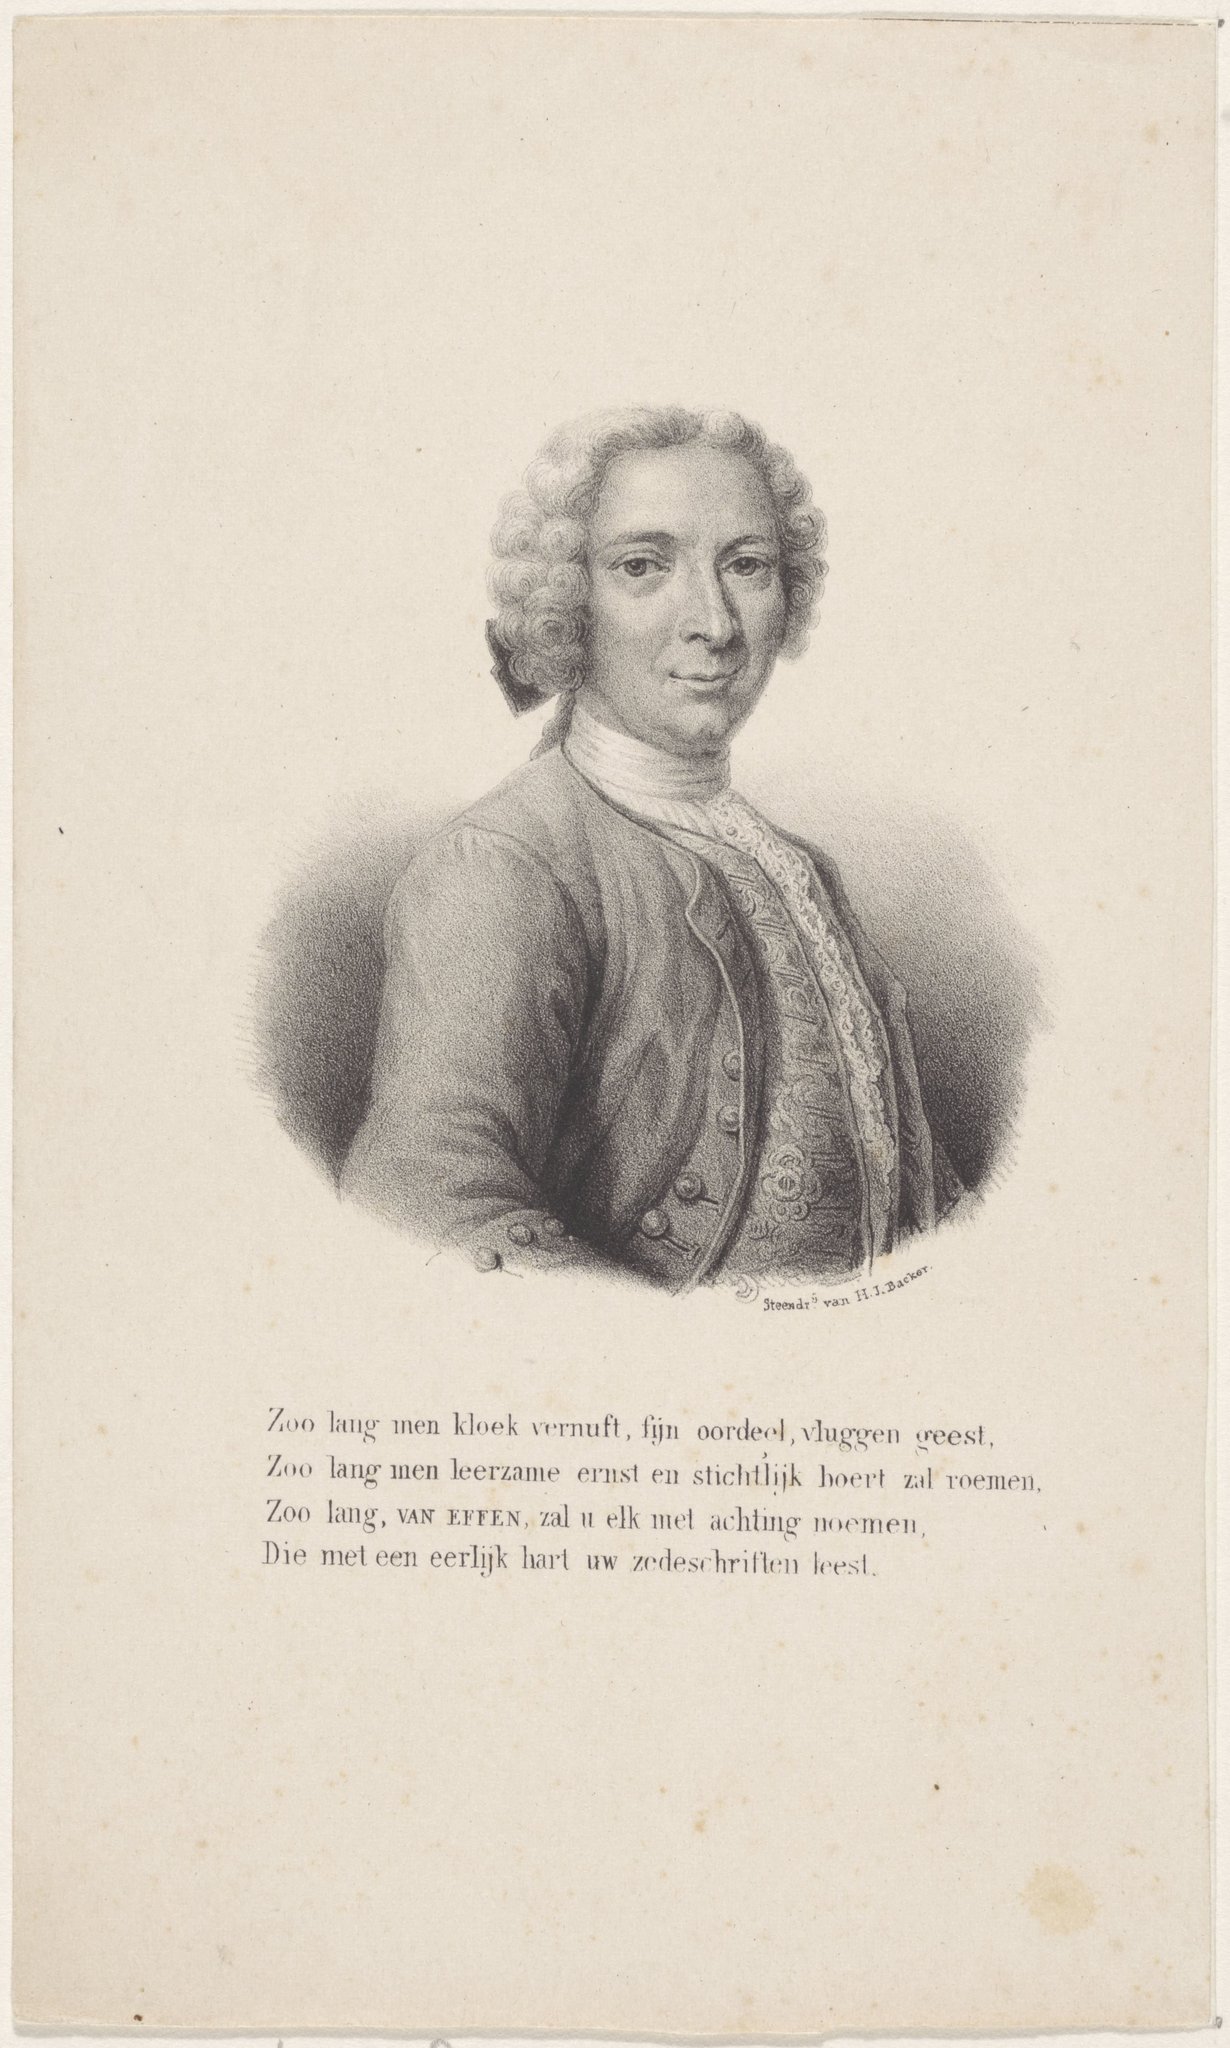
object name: print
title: Portret van de schrijver Justus van Effen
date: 1822-1845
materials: paper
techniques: lithograph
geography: dordrecht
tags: historical persons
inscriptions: collector's mark: Lugt 2228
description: Onder het portret enkele dichtregels over de geportretteerde.